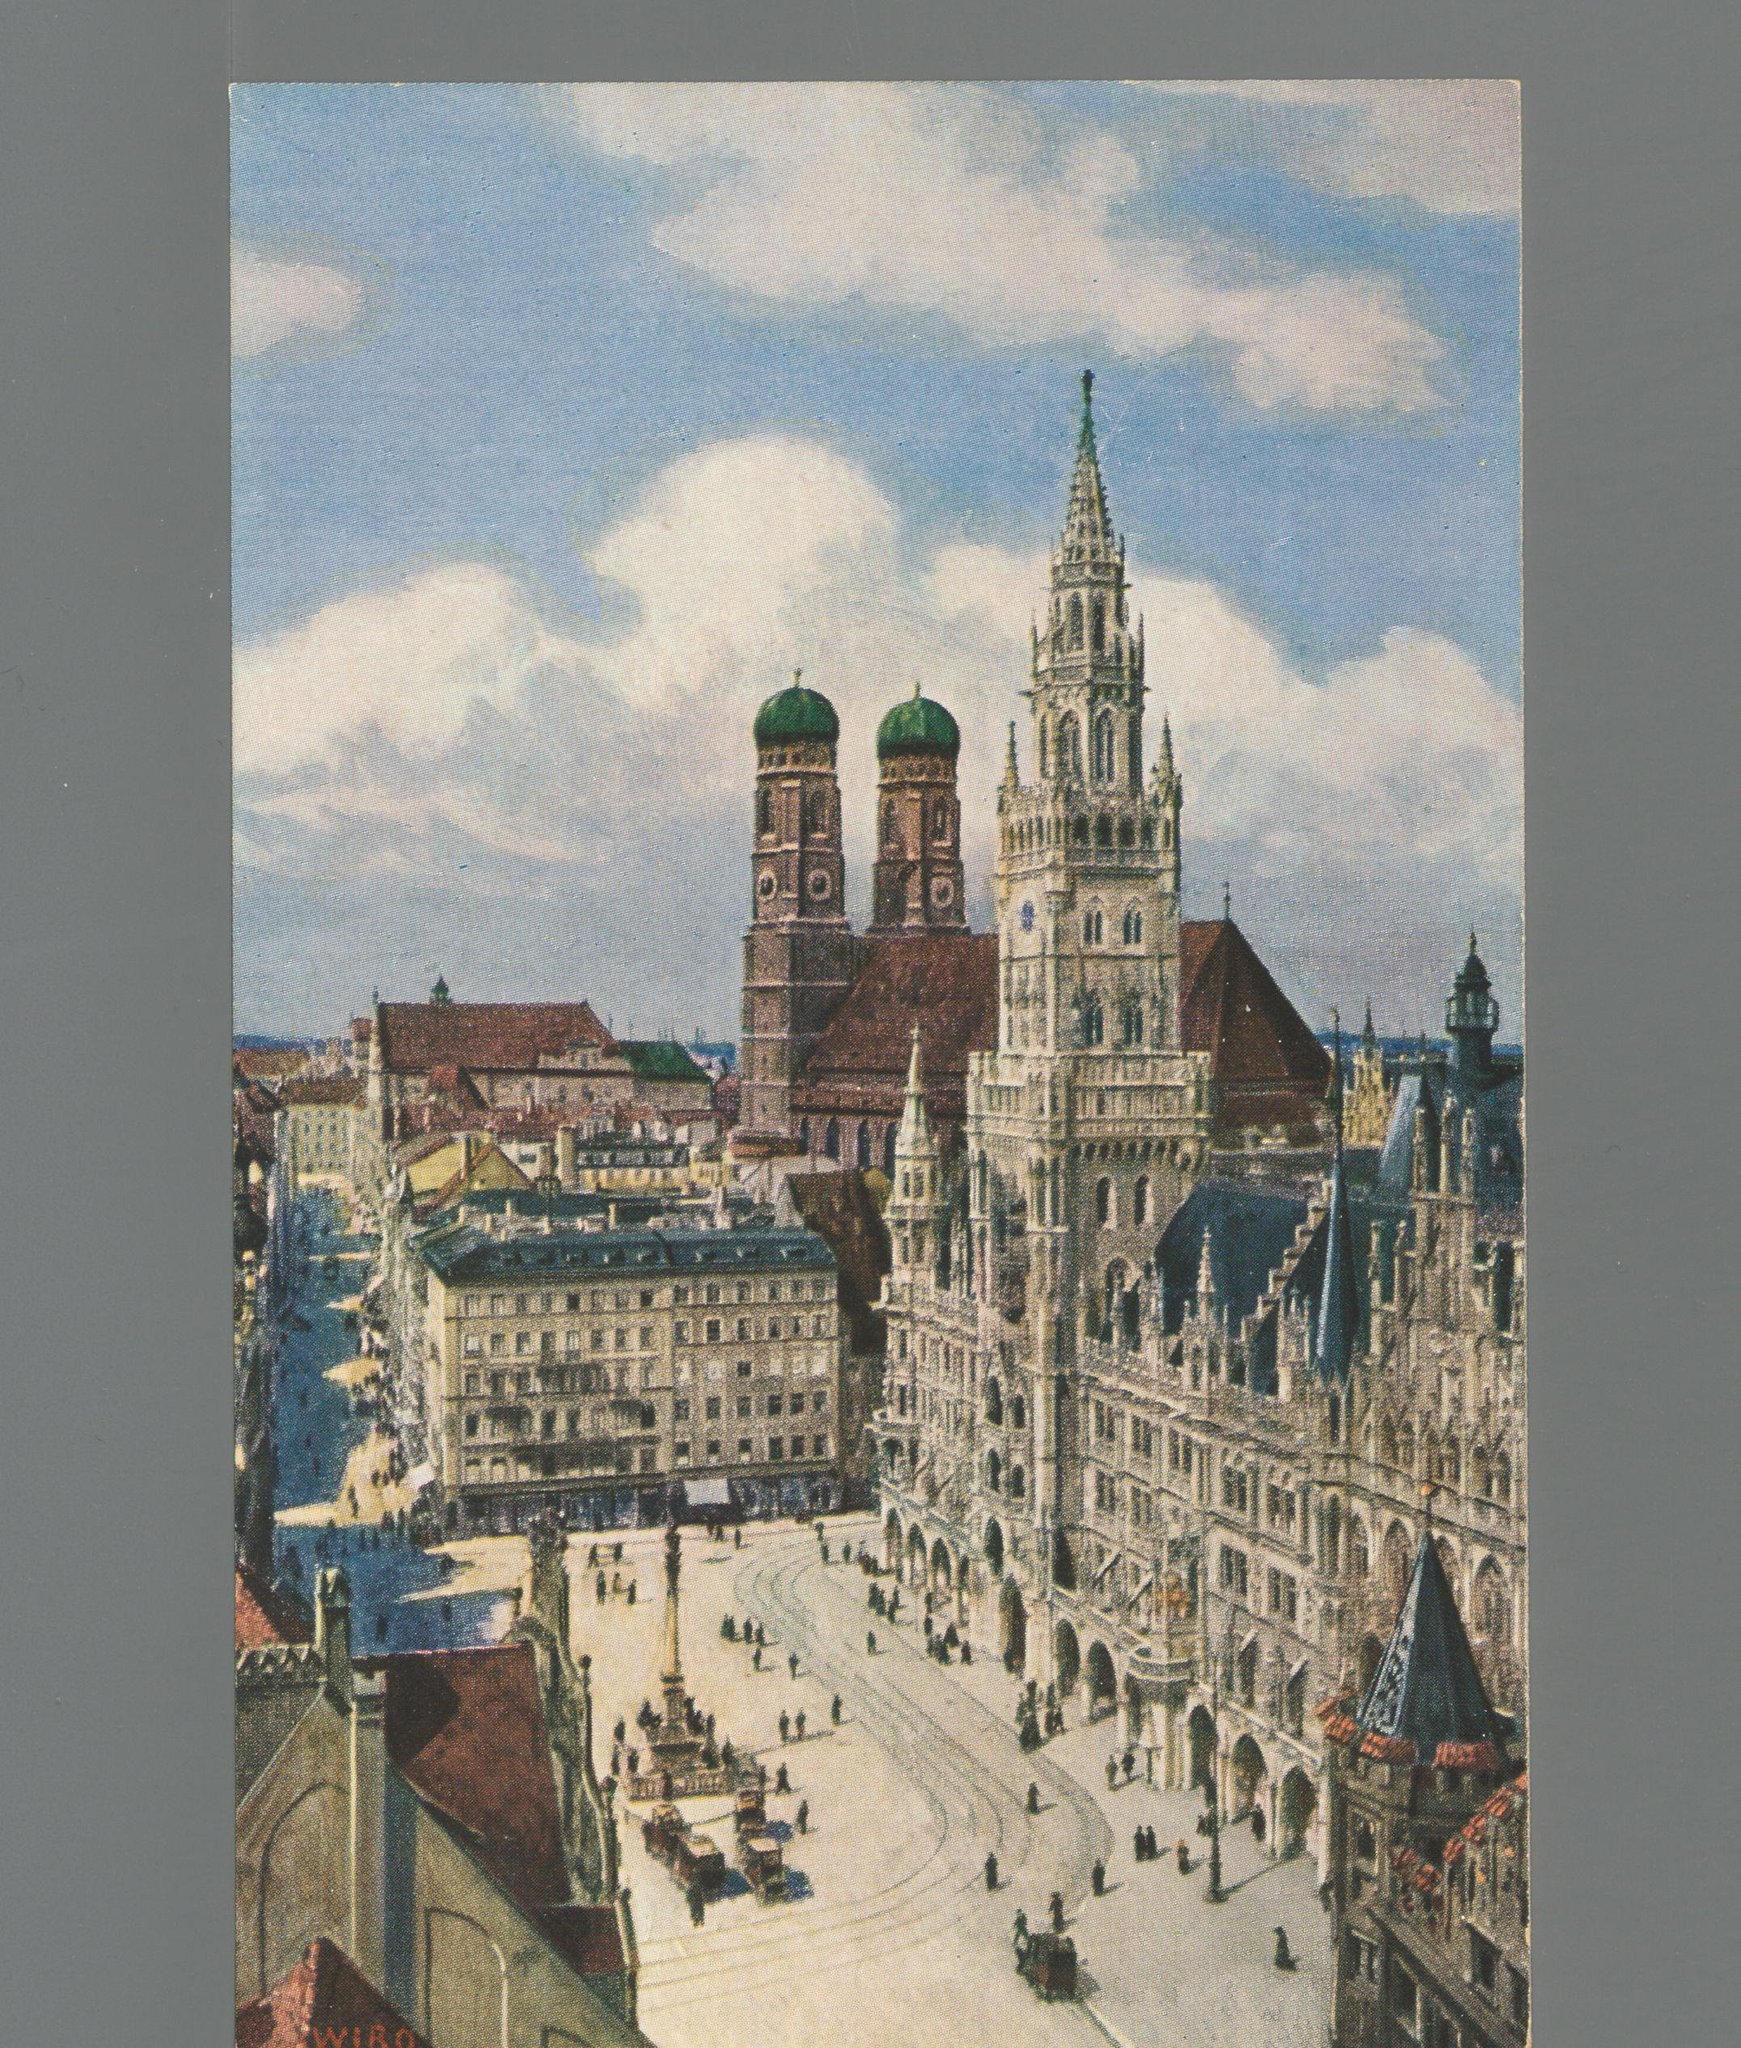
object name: photomechanical print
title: München, Marienplatz mit Rathaus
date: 1905-1930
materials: cardboard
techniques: color autotype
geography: roda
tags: square, place, circus, etc., church (exterior), townhall, monument, statue